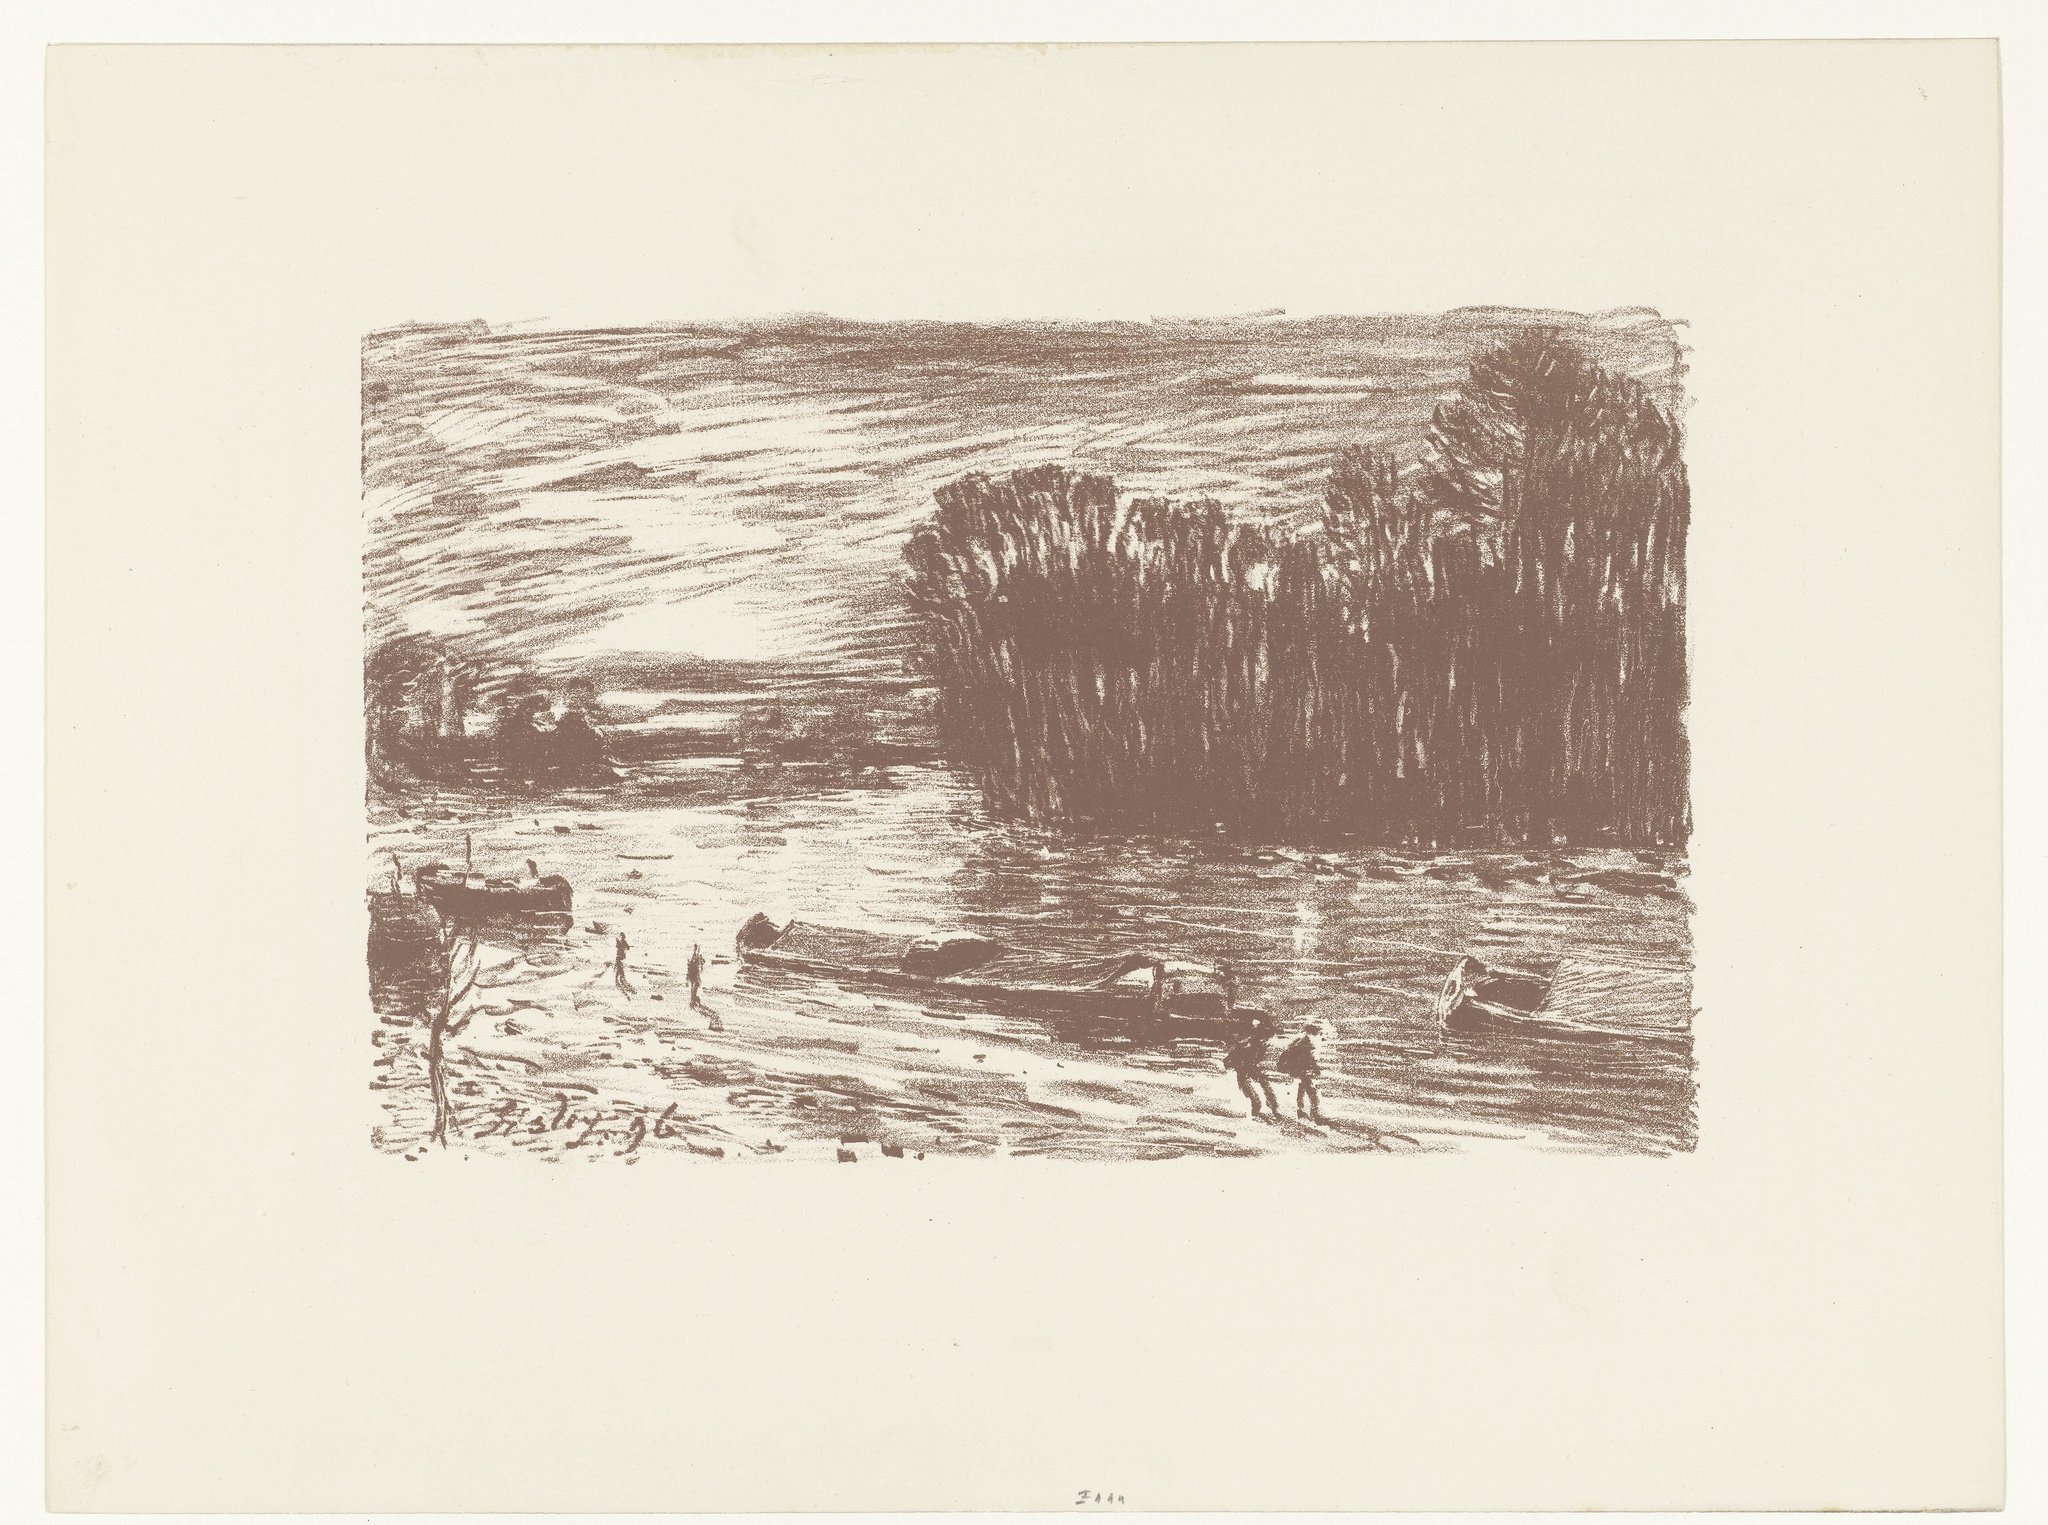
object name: print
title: Bords du Loing près Saint Mammès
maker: alfred sisley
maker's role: print maker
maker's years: 1839-1899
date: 1896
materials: paper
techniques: printing, lithograph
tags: river, river bank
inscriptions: collector's mark: Lugt 2760, collector's mark: Lugt 2228